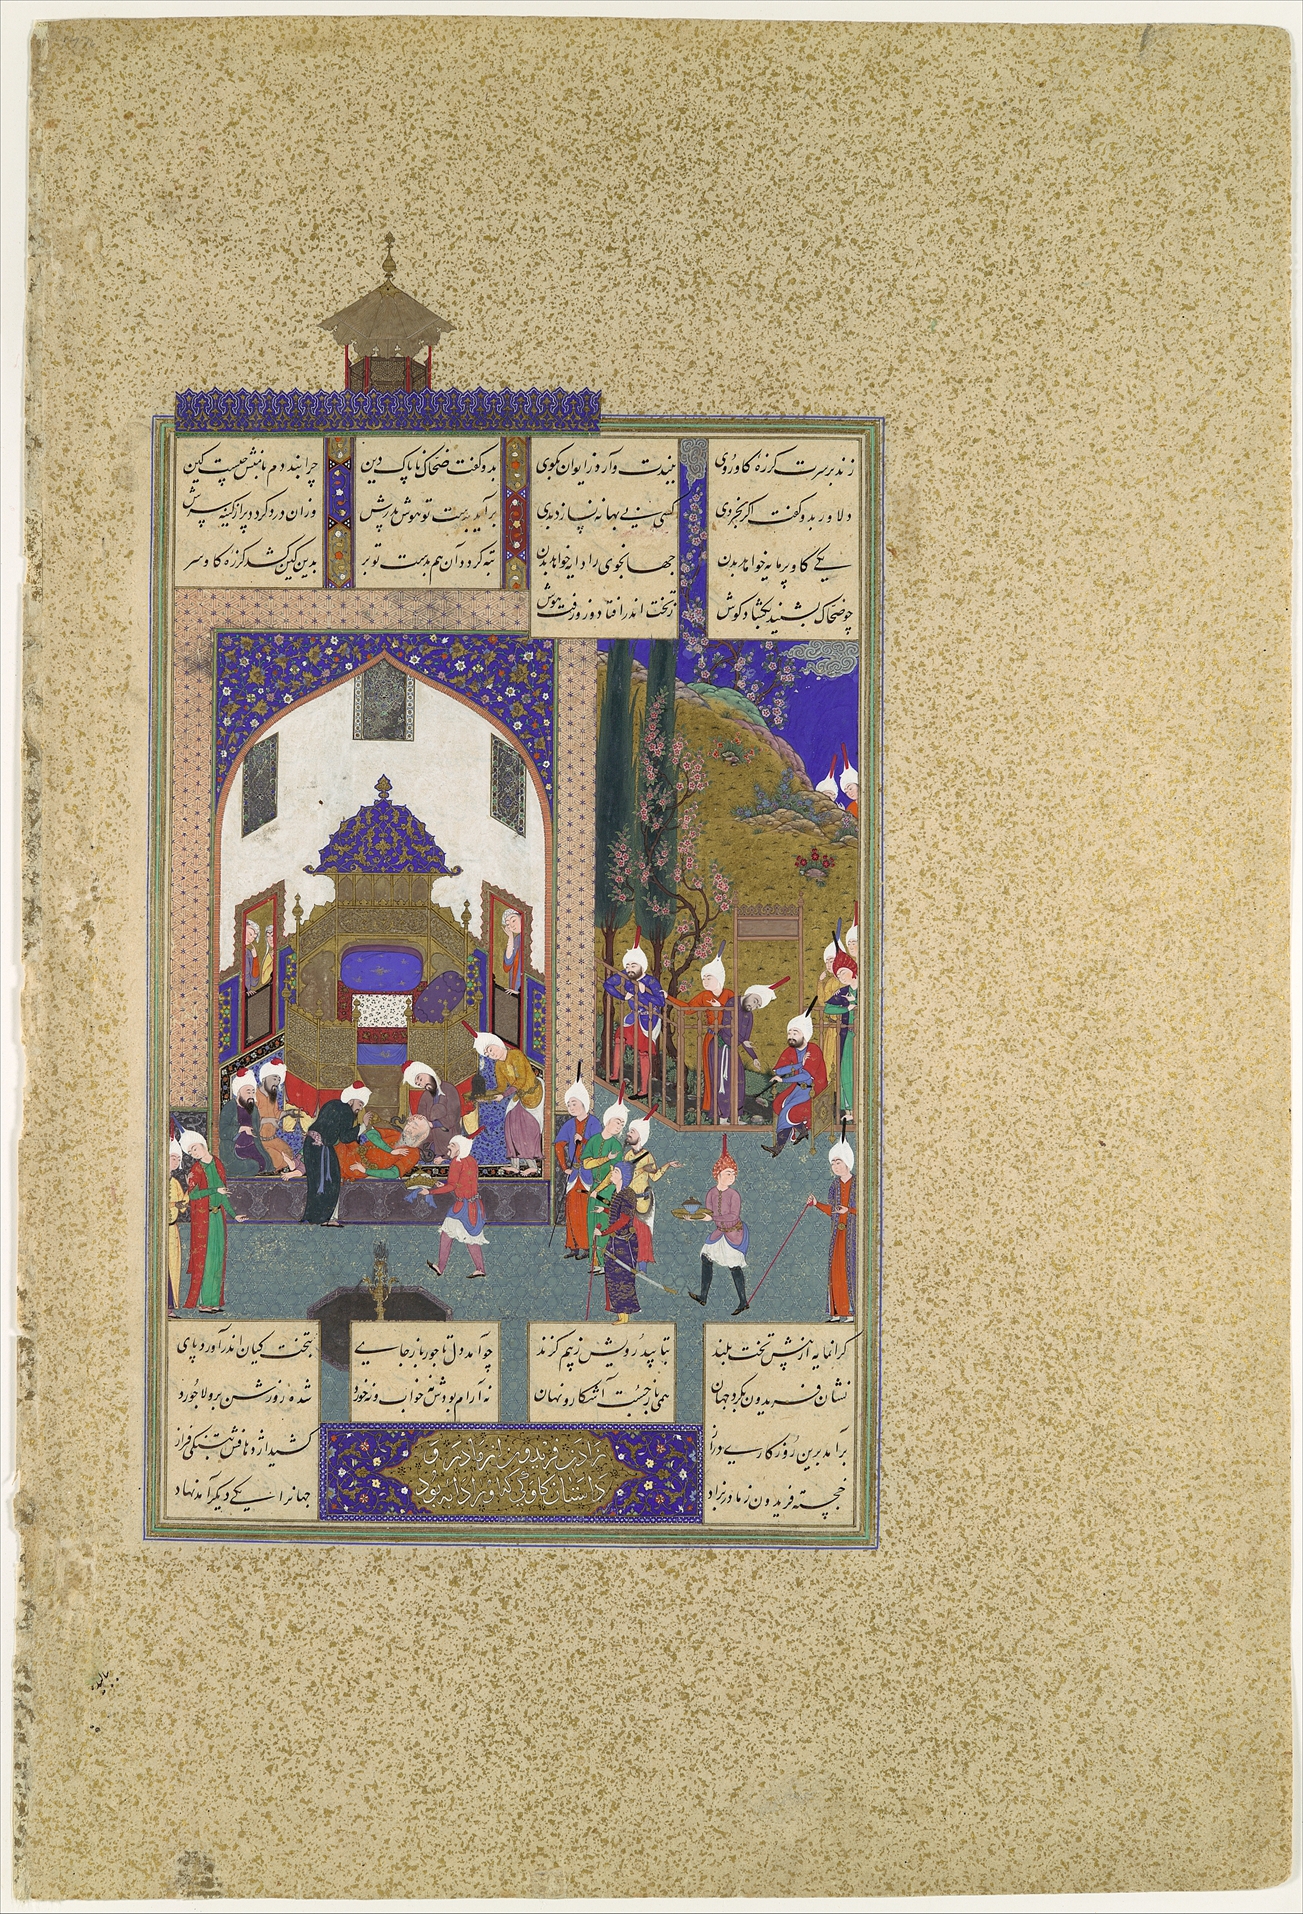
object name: folio from an illustrated manuscript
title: "Zahhak is Told His Fate", Folio 29v from the Shahnama (Book of Kings) of Shah Tahmasp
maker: abu'l qasim firdausi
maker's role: author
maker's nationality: iranian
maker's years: 935-1020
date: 1524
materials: gold, ink, paper, silver, watercolor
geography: iran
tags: men